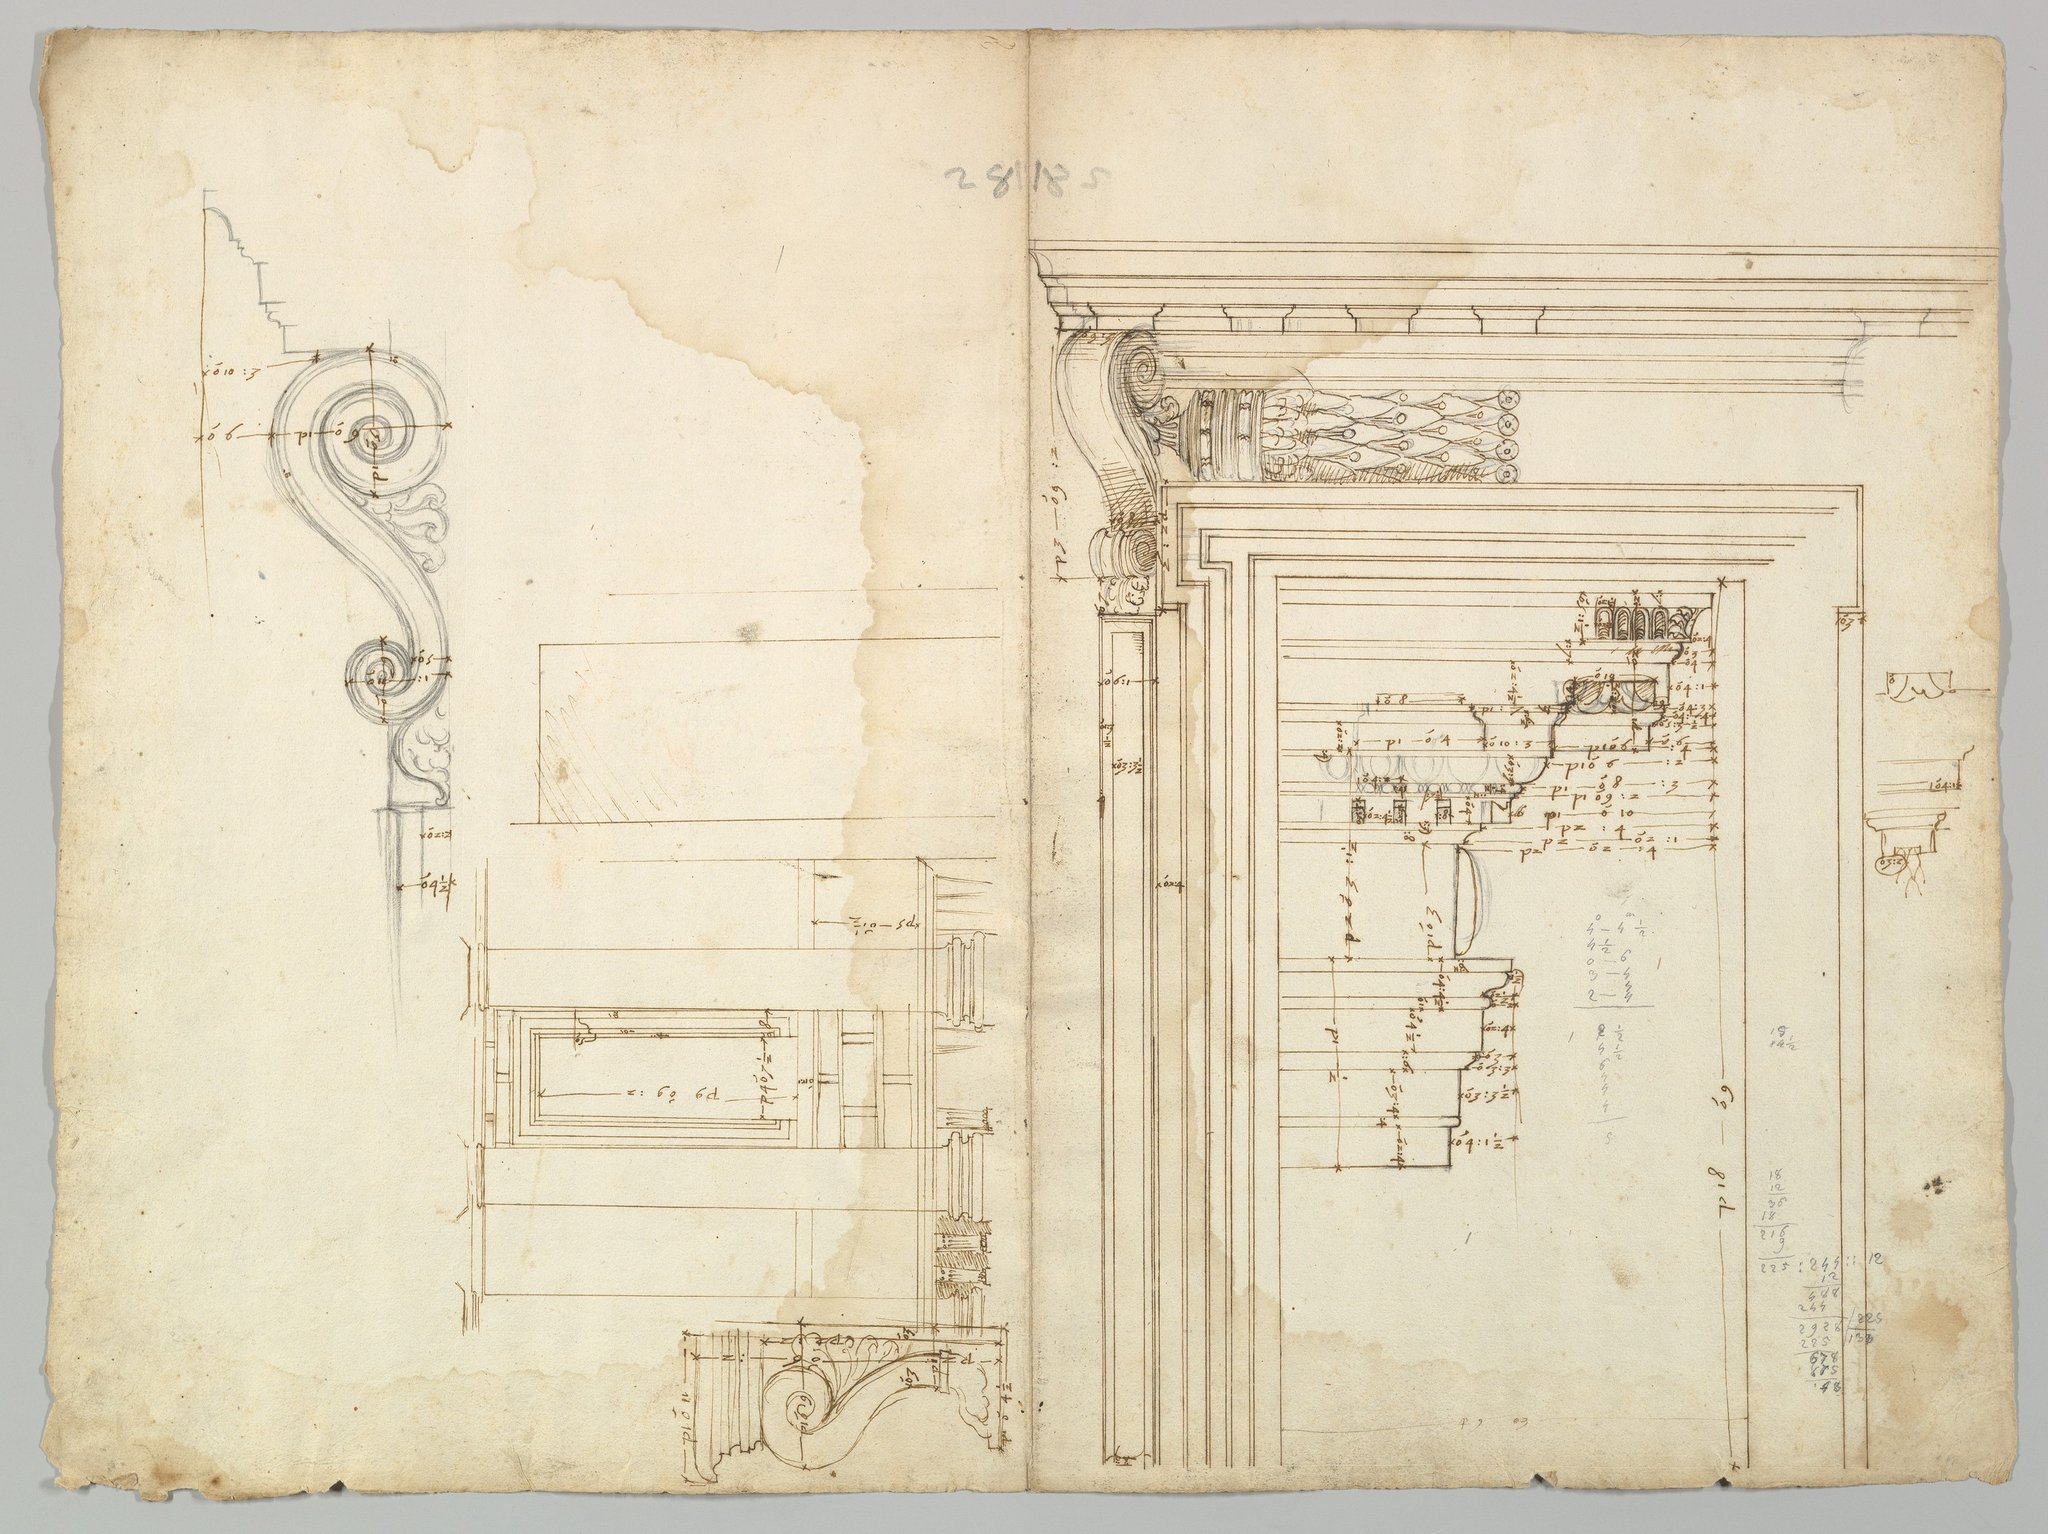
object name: drawing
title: Palazzo Massimo alle Colonne, portico, elevation; portal, cornice, section; portal bracket, detail; fireplace, detail (recto) blank (verso)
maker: anonymous, french, 16th century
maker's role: draftsman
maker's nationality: french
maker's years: 1500-1600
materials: chalk, ink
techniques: incising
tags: architecture